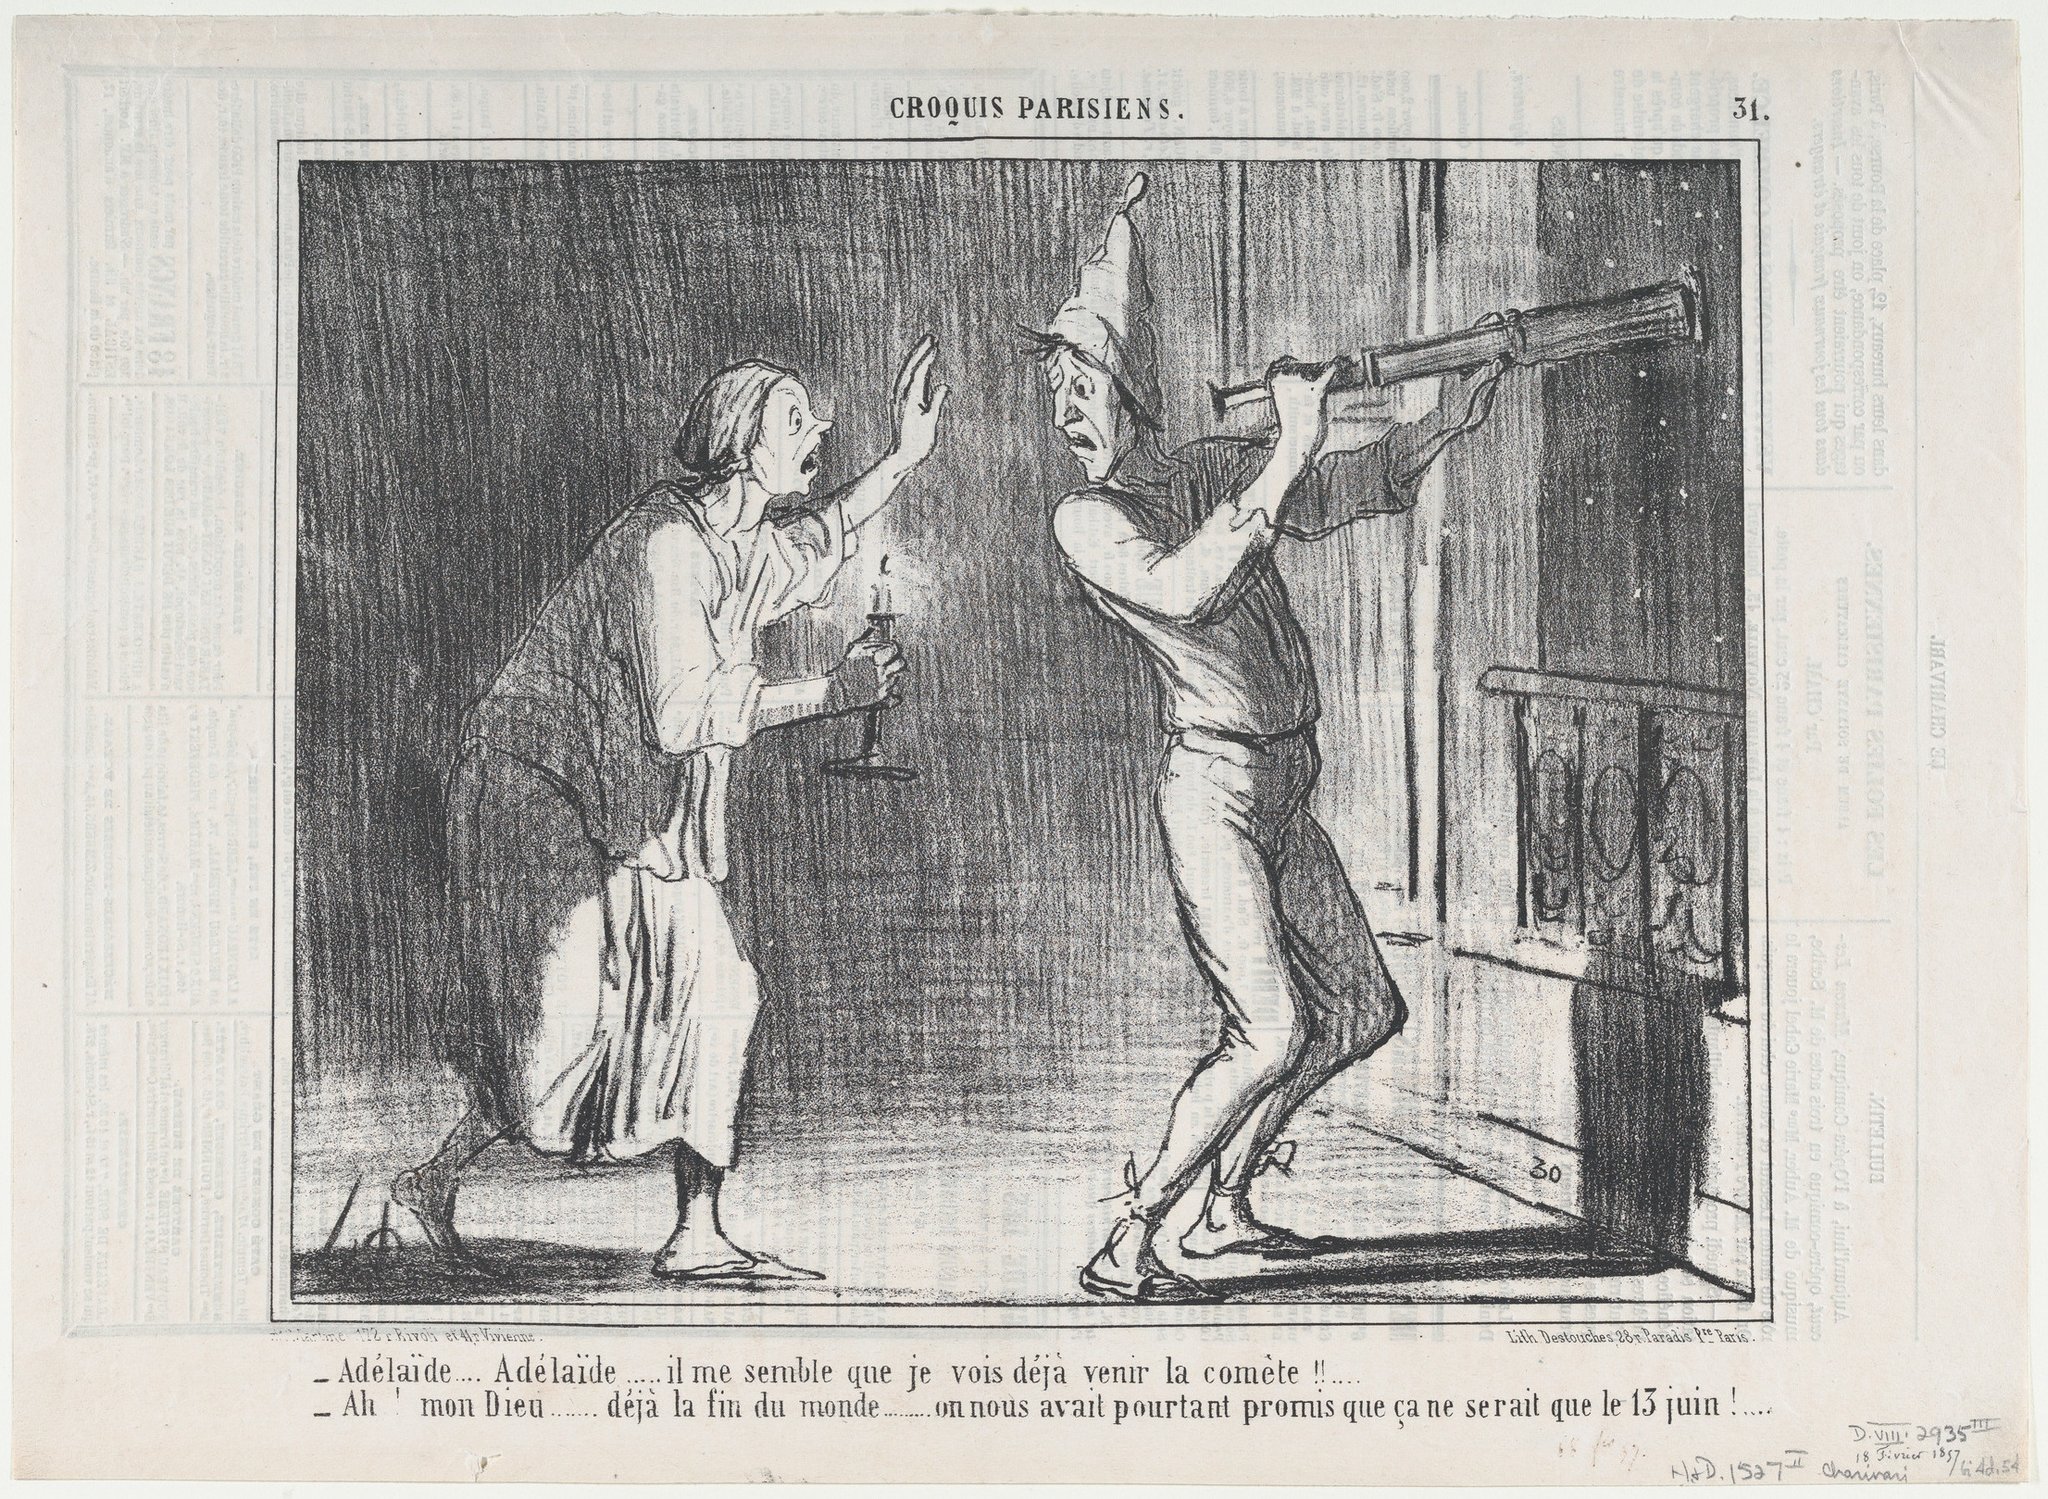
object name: print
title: Adèlaïde... Il me semble que je vois... la comète! (Adelaide... I think I see the comet!), from "Croquis Parisiens"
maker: honoré daumier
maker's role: artist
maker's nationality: french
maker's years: 1808-1879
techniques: lithograph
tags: satire,men,women,telescopes